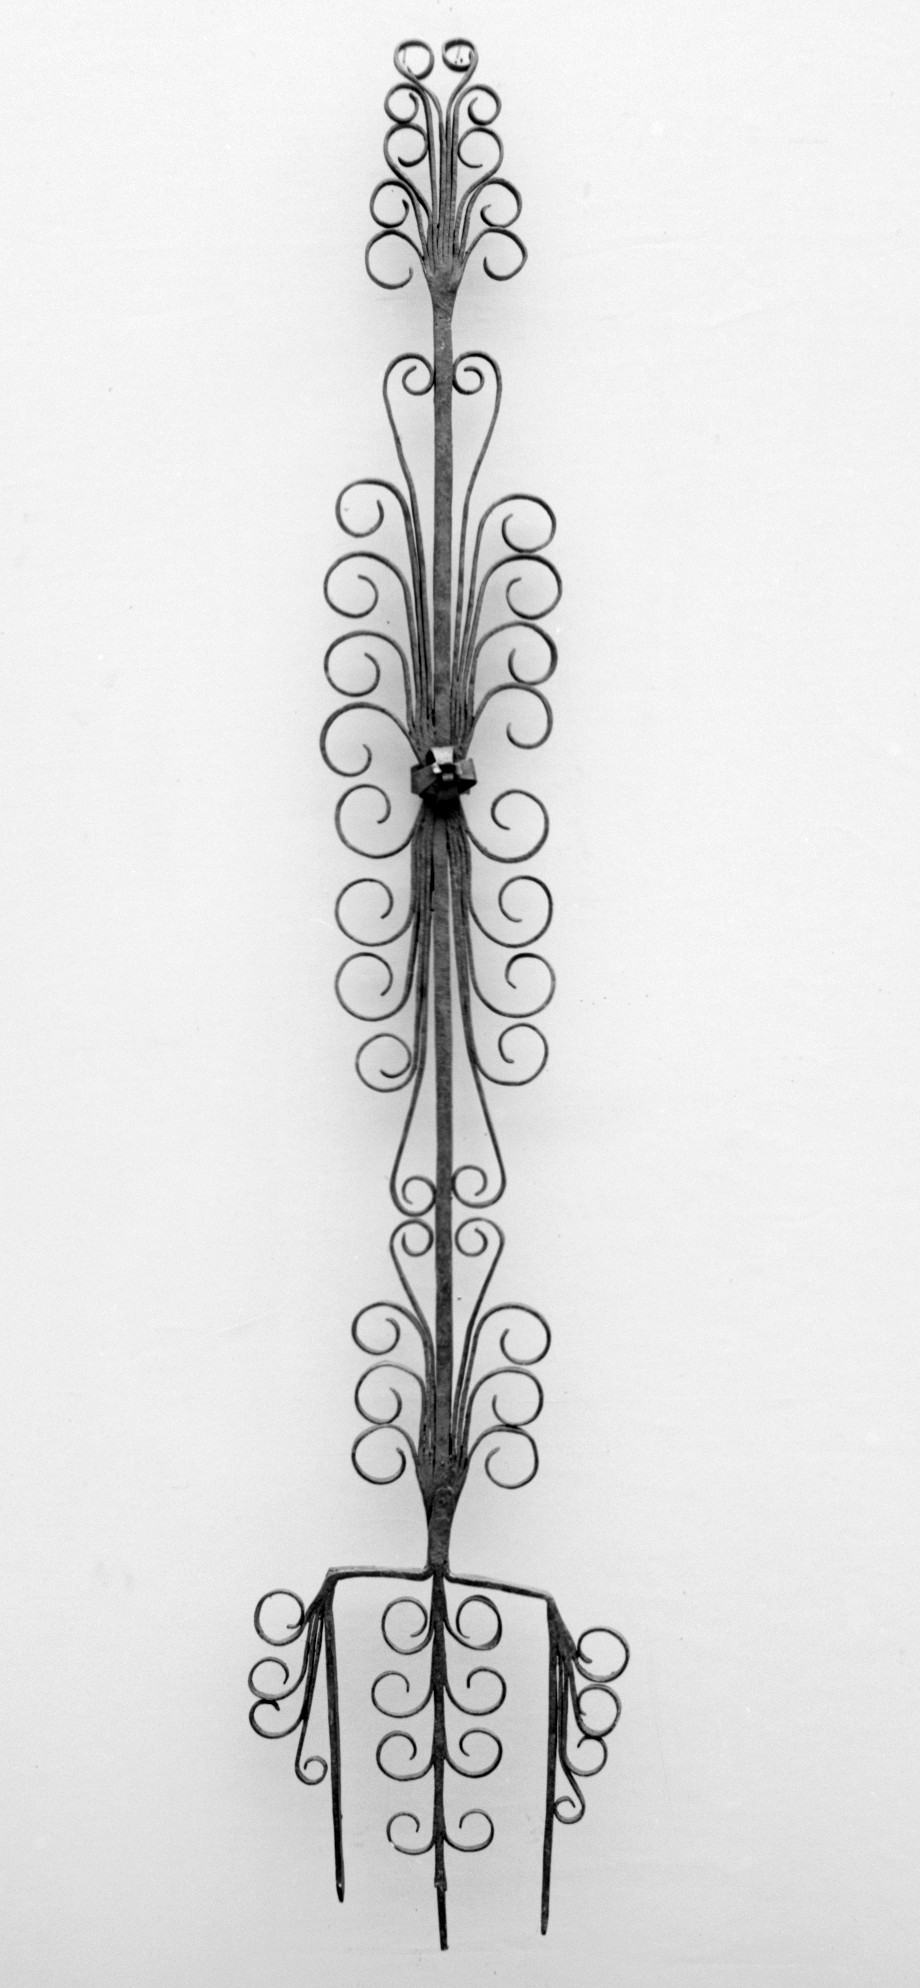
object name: fork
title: Broaching or toasting fork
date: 1601-1700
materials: iron